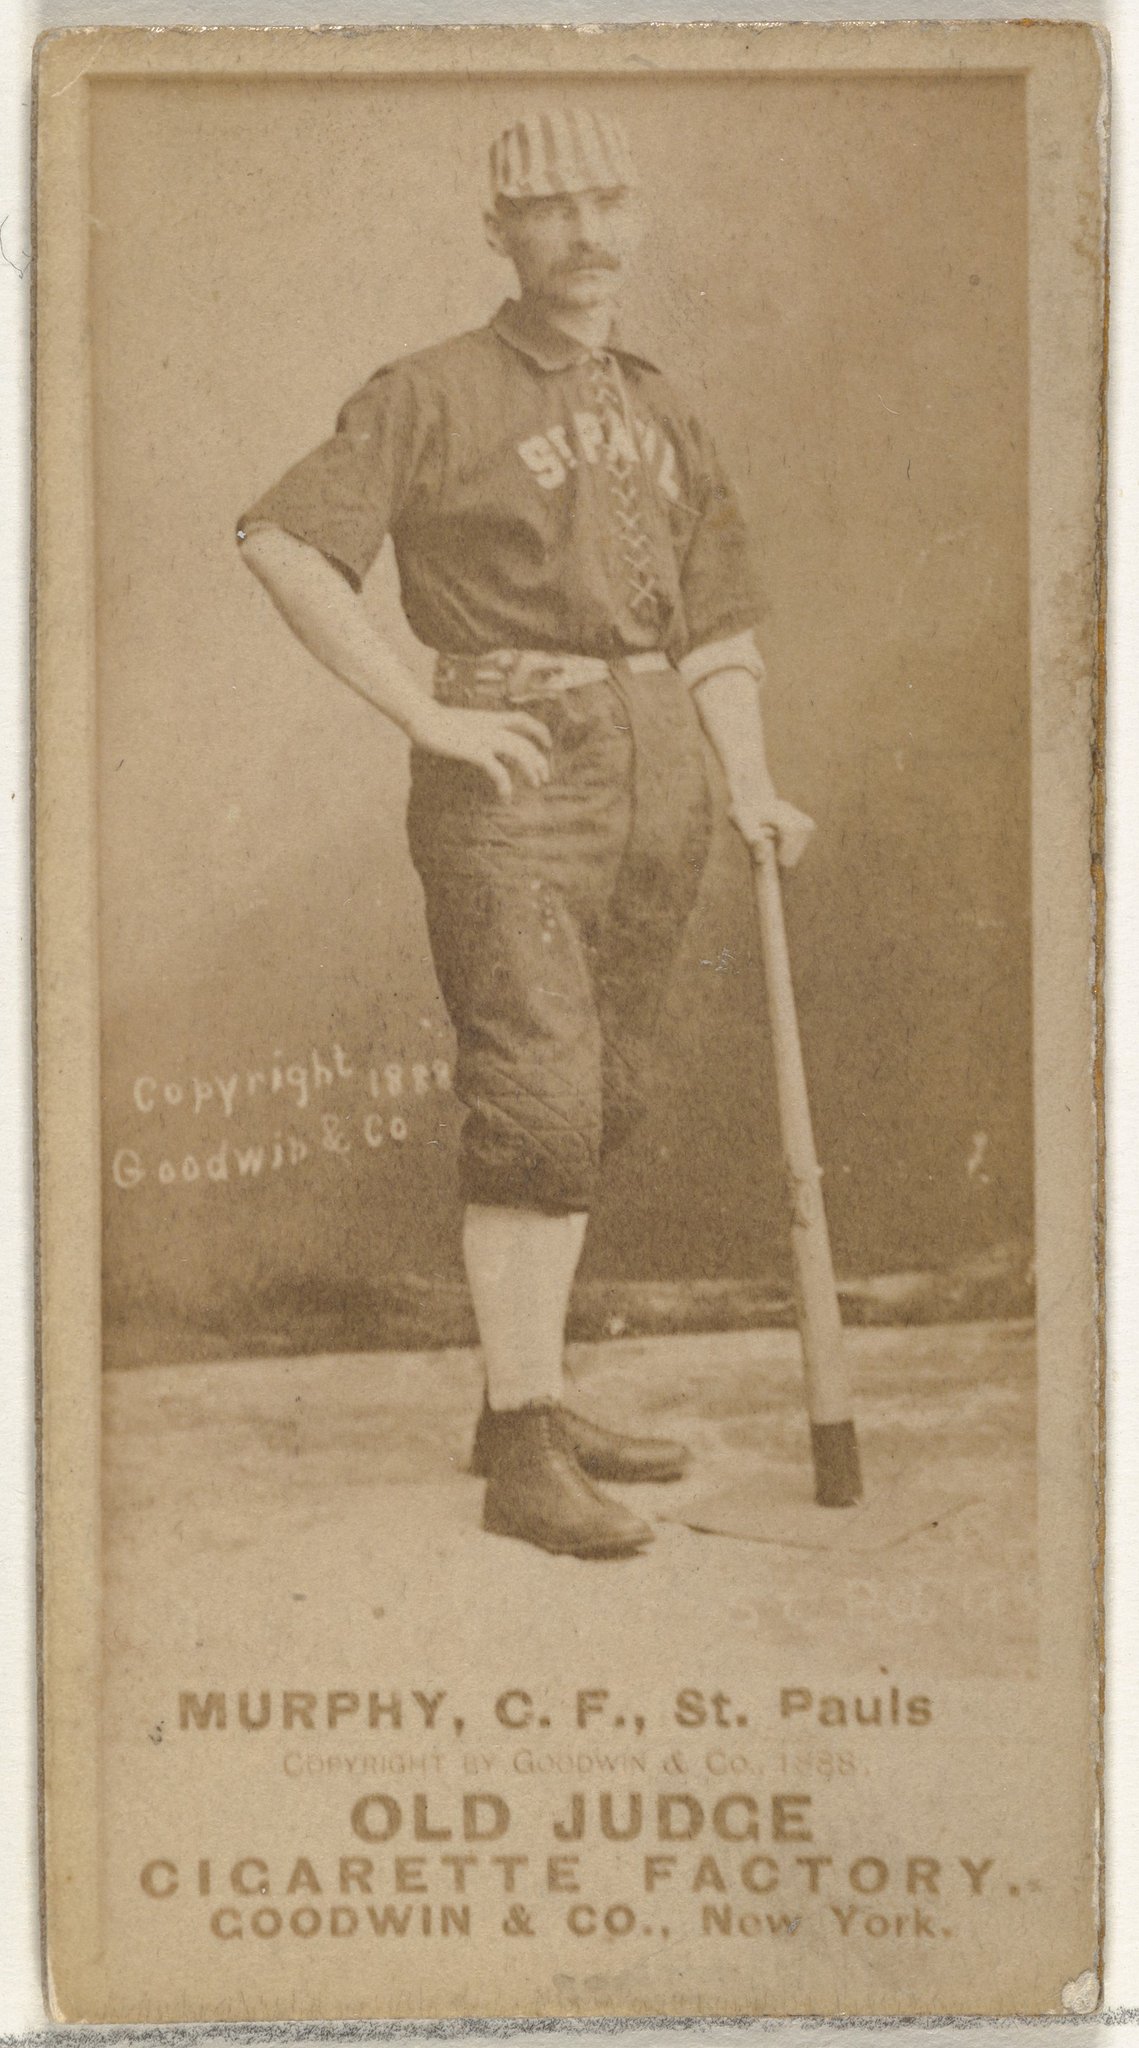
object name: baseball card, photograph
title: Patrick Lawrence "Larry" Murphy, Center Field, St. Paul Apostles, from the Old Judge series (N172) for Old Judge Cigarettes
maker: goodwin & company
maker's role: publisher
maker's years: 1850-1950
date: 1888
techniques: albumen silver print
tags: men,portraits,baseball,athletes